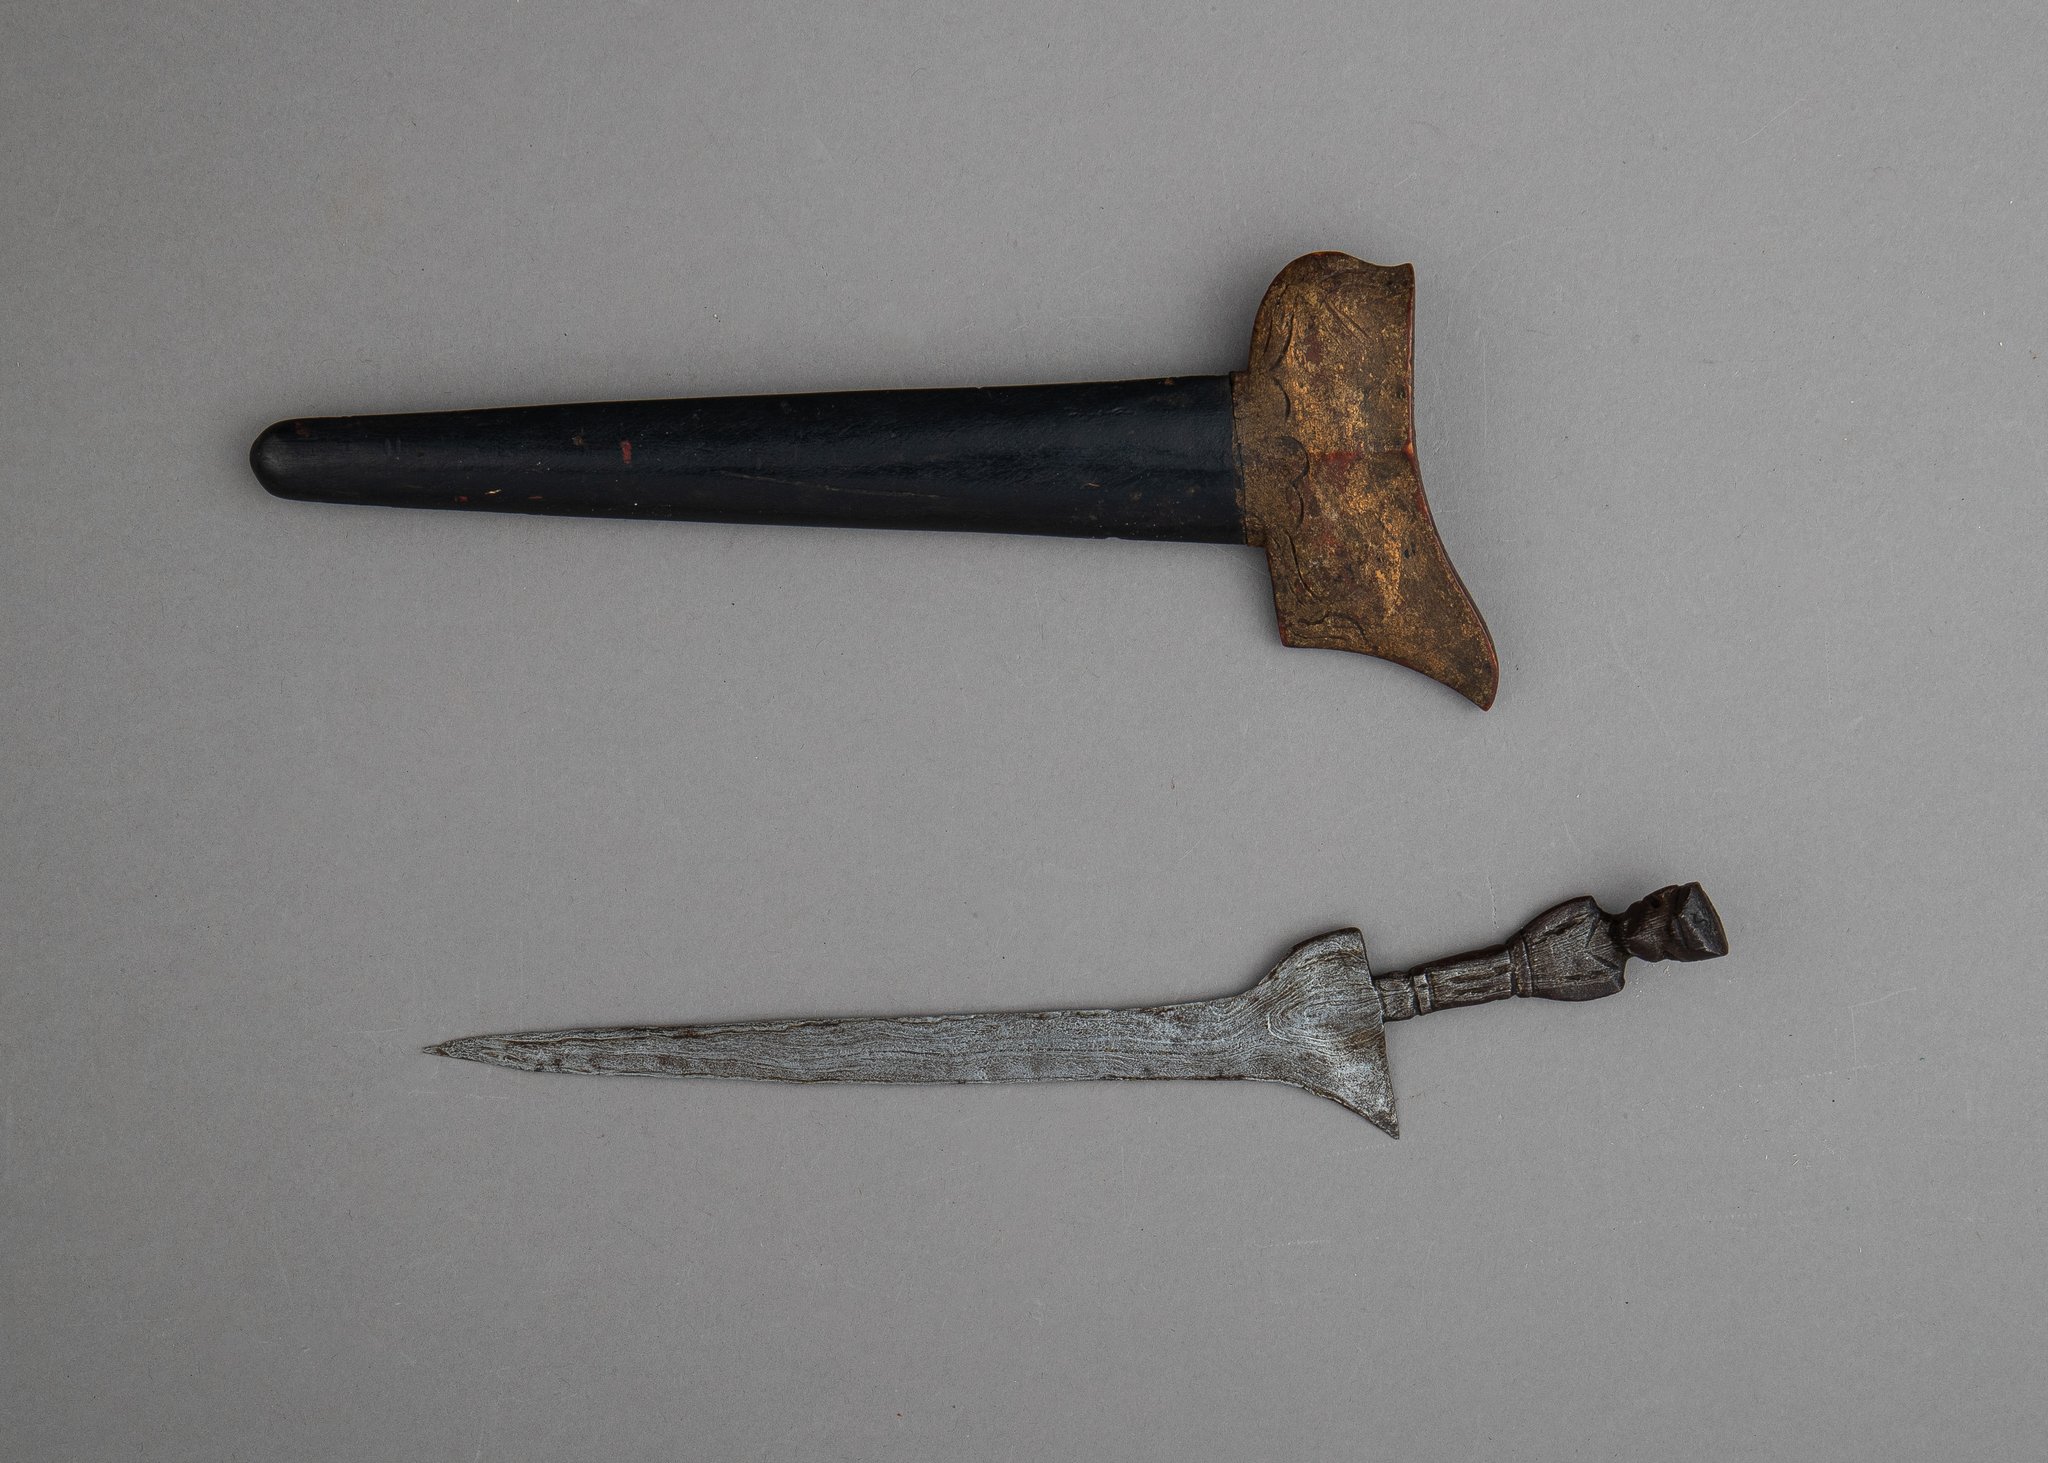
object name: kris with sheath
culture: javanese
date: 1501-1900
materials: steel, wood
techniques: polychromy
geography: indonesia